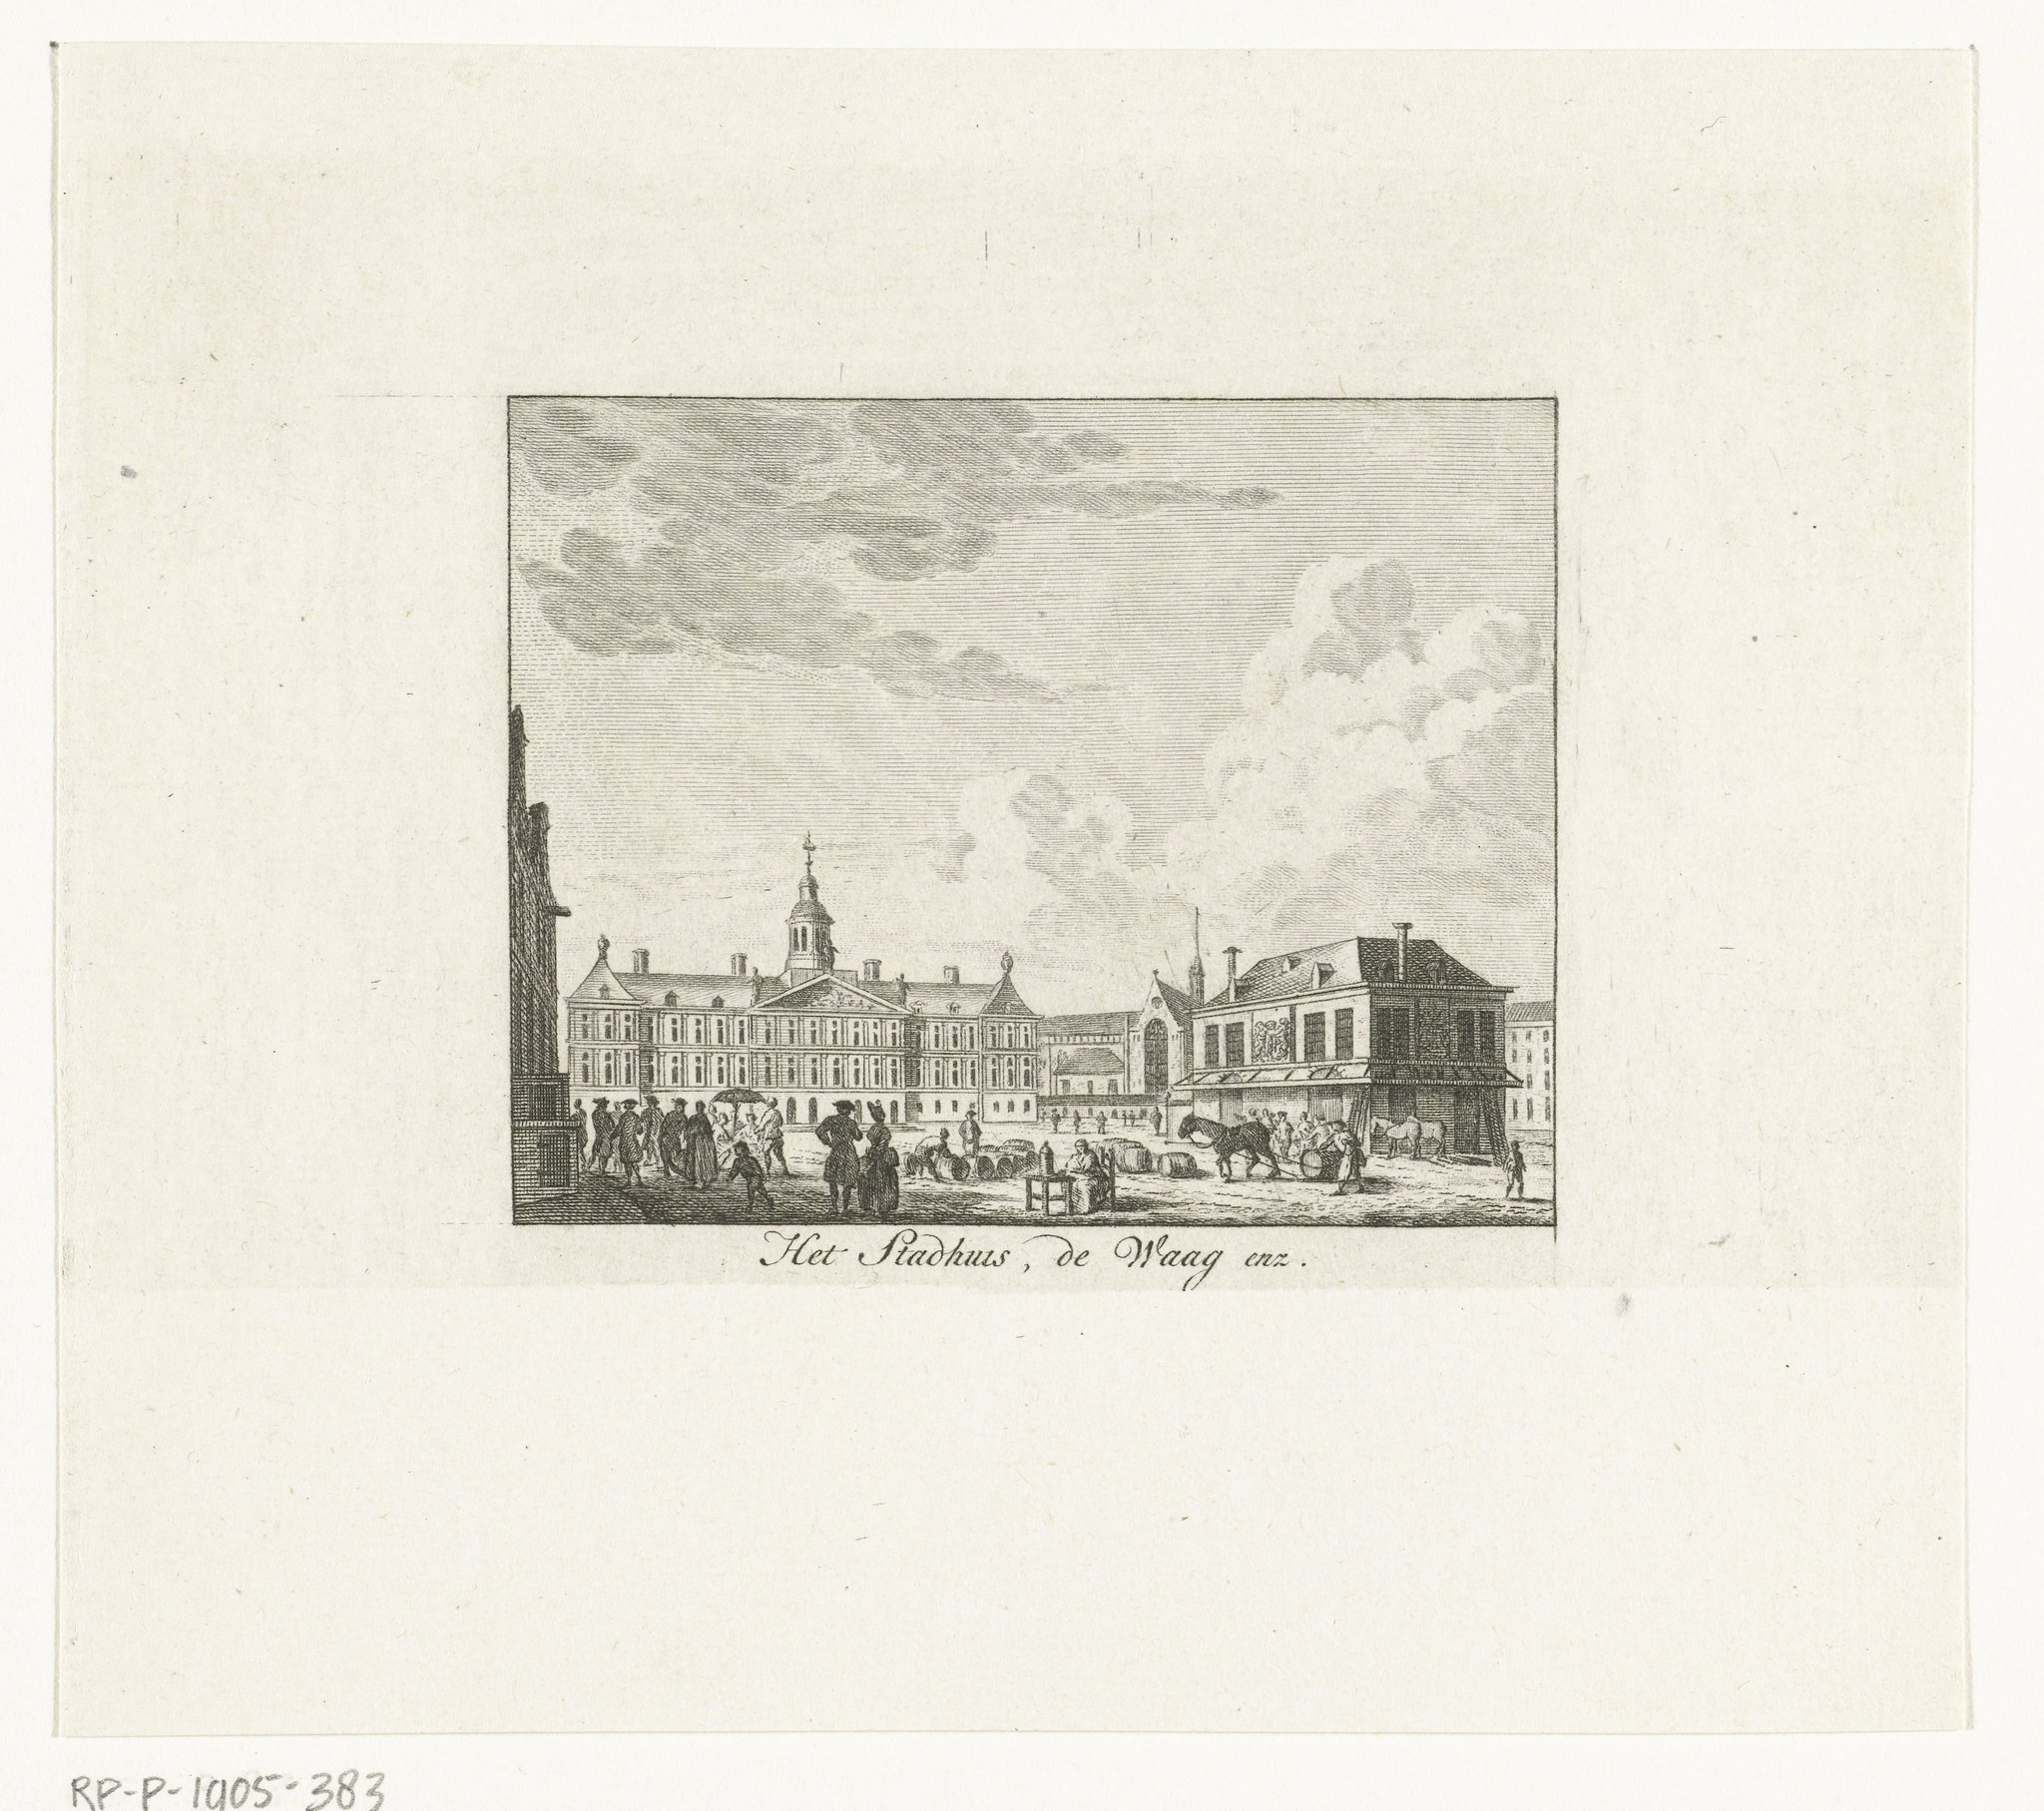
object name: print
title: Het Stadhuis, de Waag enz.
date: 1782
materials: paper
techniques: etching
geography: netherlands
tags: city-view in general; 'veduta'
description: Prent mogelijk naar tekening van Hendrik Keun.